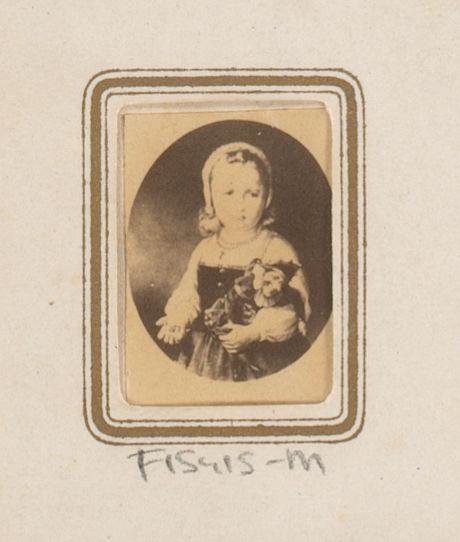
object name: photograph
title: Miniatuurfotoreproductie van een schilderij voorstellende een kind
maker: Anonymous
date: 1860-1870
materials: paper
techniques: albumen print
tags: child, picture, painting